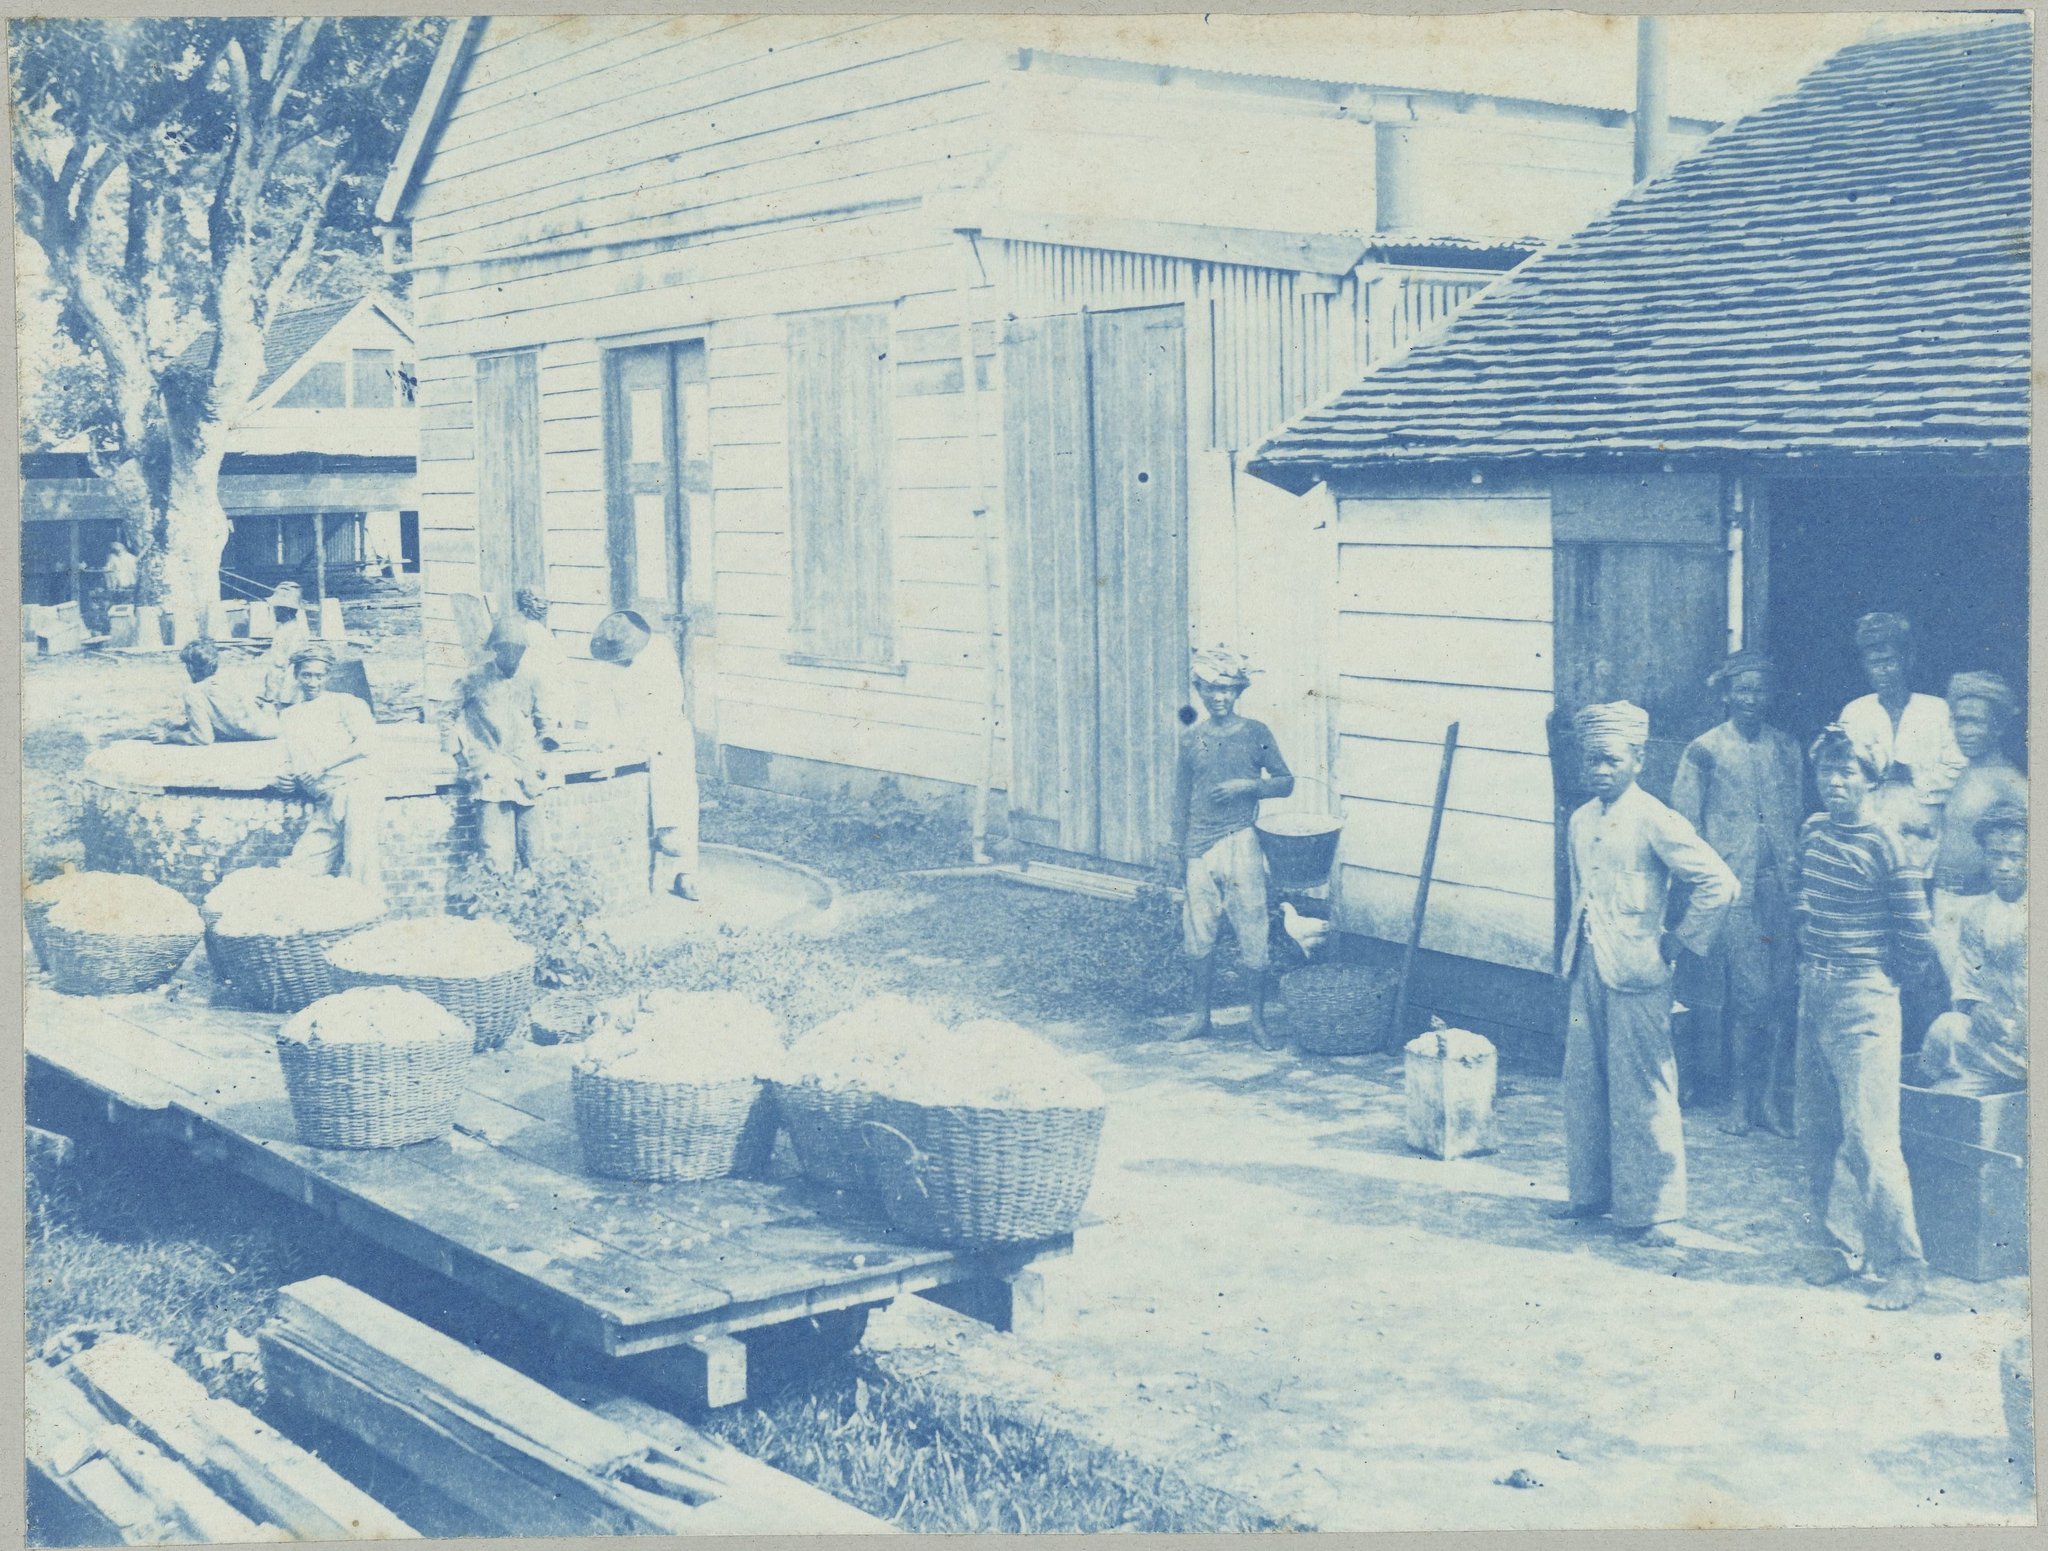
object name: photograph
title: Aanvoer van cacao op "Ma retraite"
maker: hendrik doijer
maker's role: engineer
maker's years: 1863-1925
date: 1903-1910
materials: photographic support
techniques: cyanotype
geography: suriname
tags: suriname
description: Werknemers staande bij manden met geoogste cacaobonen of cacaovruchten bij loodsen op het terrein van de plantage Ma Retraite. Onderdeel van het fotoalbum Souvenir de Voyage (deel 1), over het leven van de familie Doijer in en rond de plantage Ma Retraite in Suriname in de jaren 1903-1910.